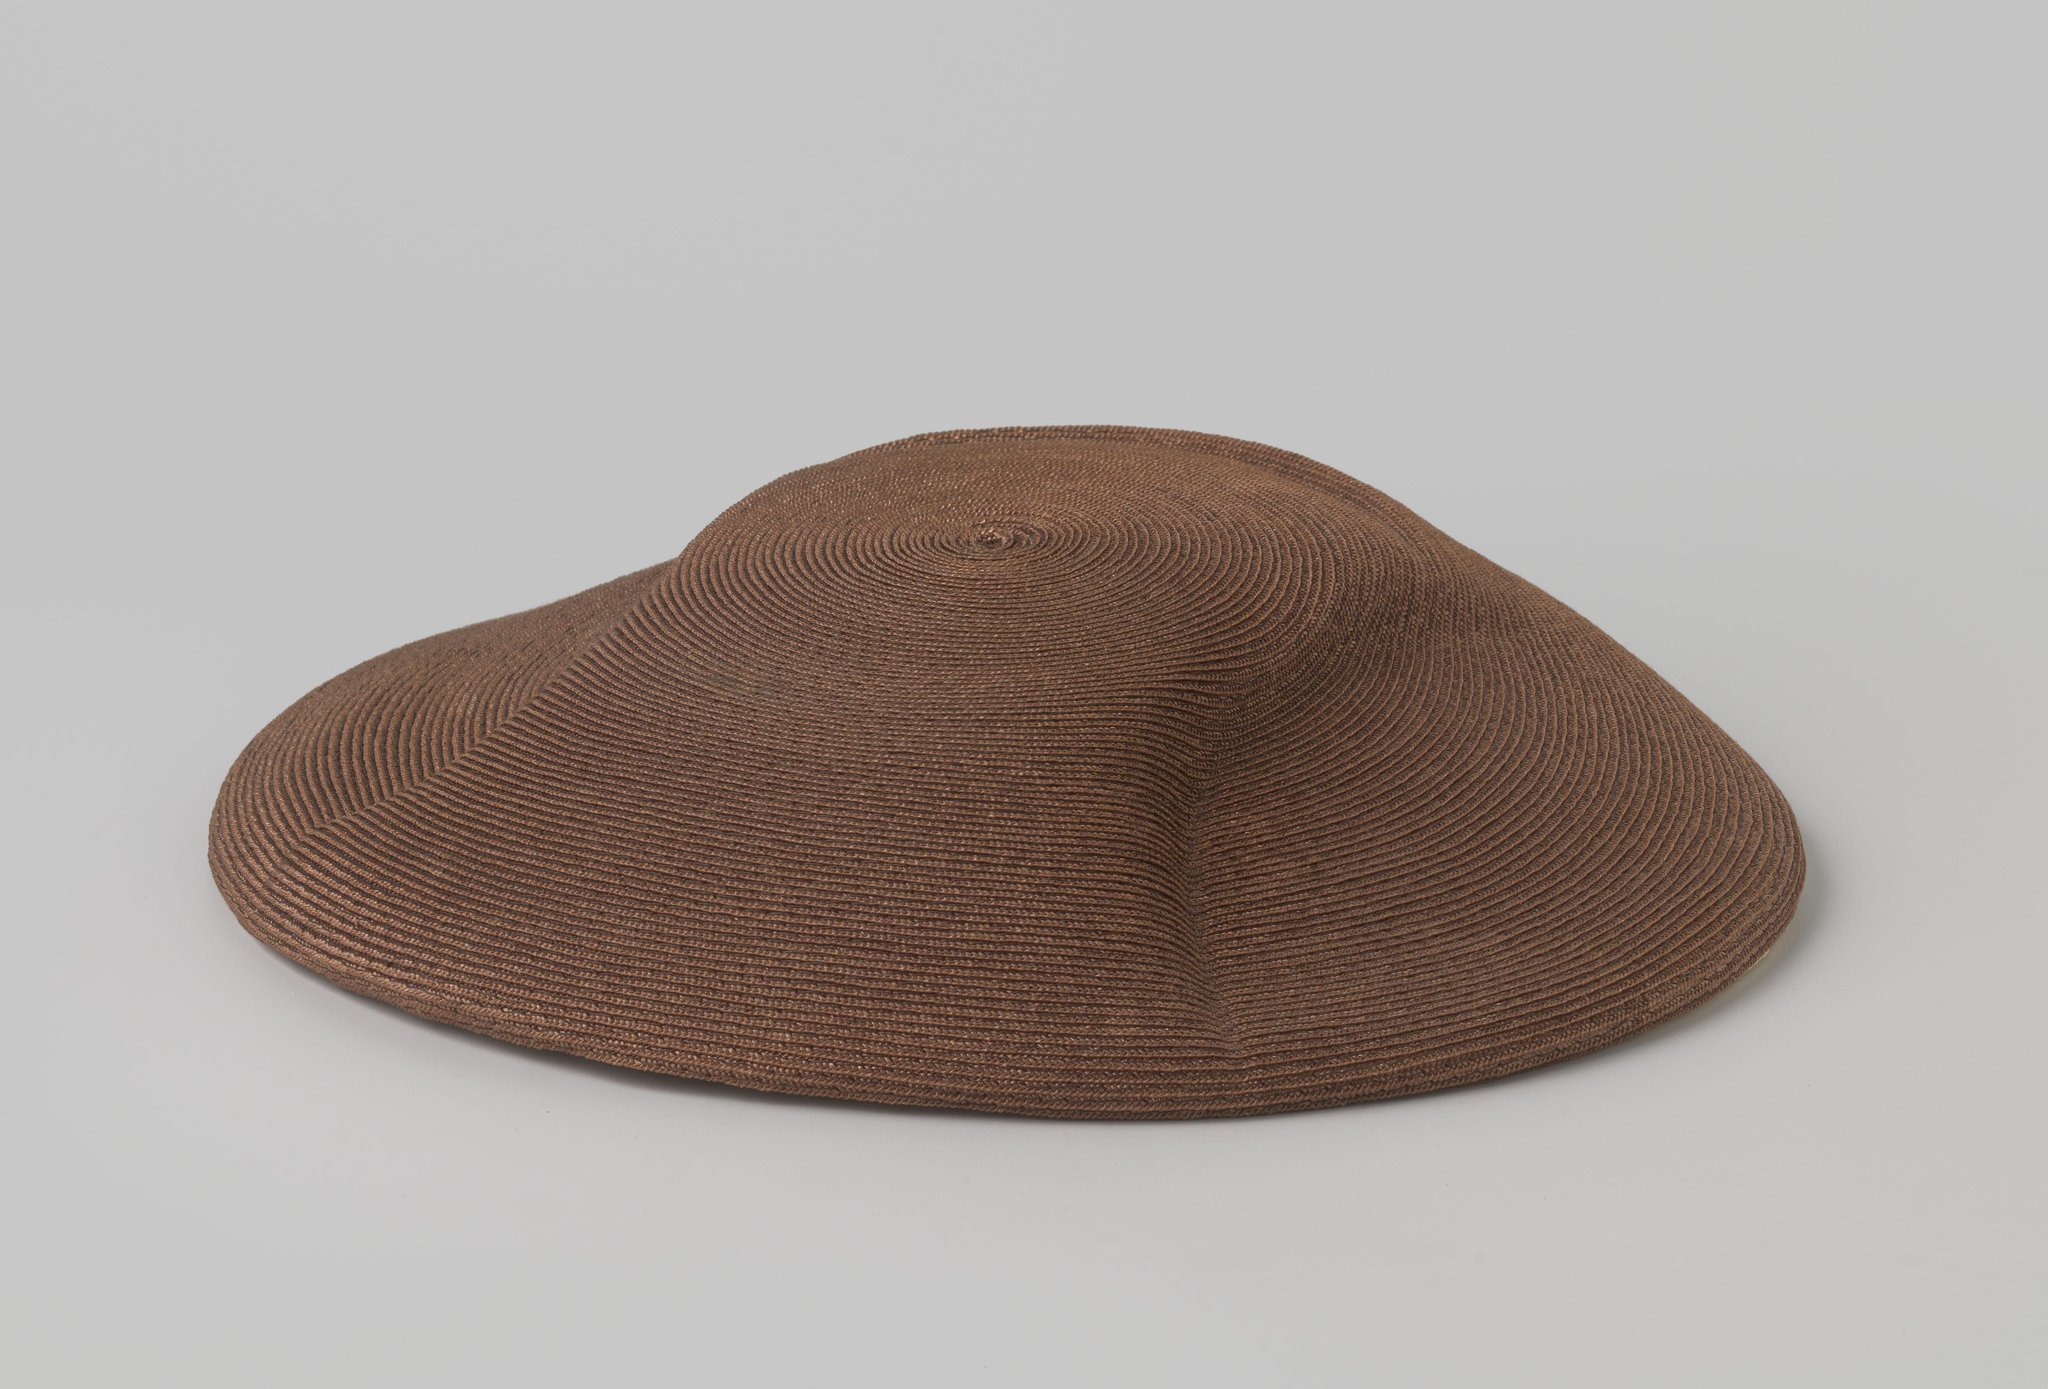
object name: womenswear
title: Hoed van fijn, bruin en naturel stro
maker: Anonymous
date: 1954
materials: straw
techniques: braiding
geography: netherlands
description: Hoed van fijn, bruin en naturel stro. Gemaakt van rondgelegde vlechtbandjes. Plat model, als een brede baret, met twee ingestreken ringdeuken. Randbeleg aan de binnenzijde, van naturel, naar geel gaand, stro.